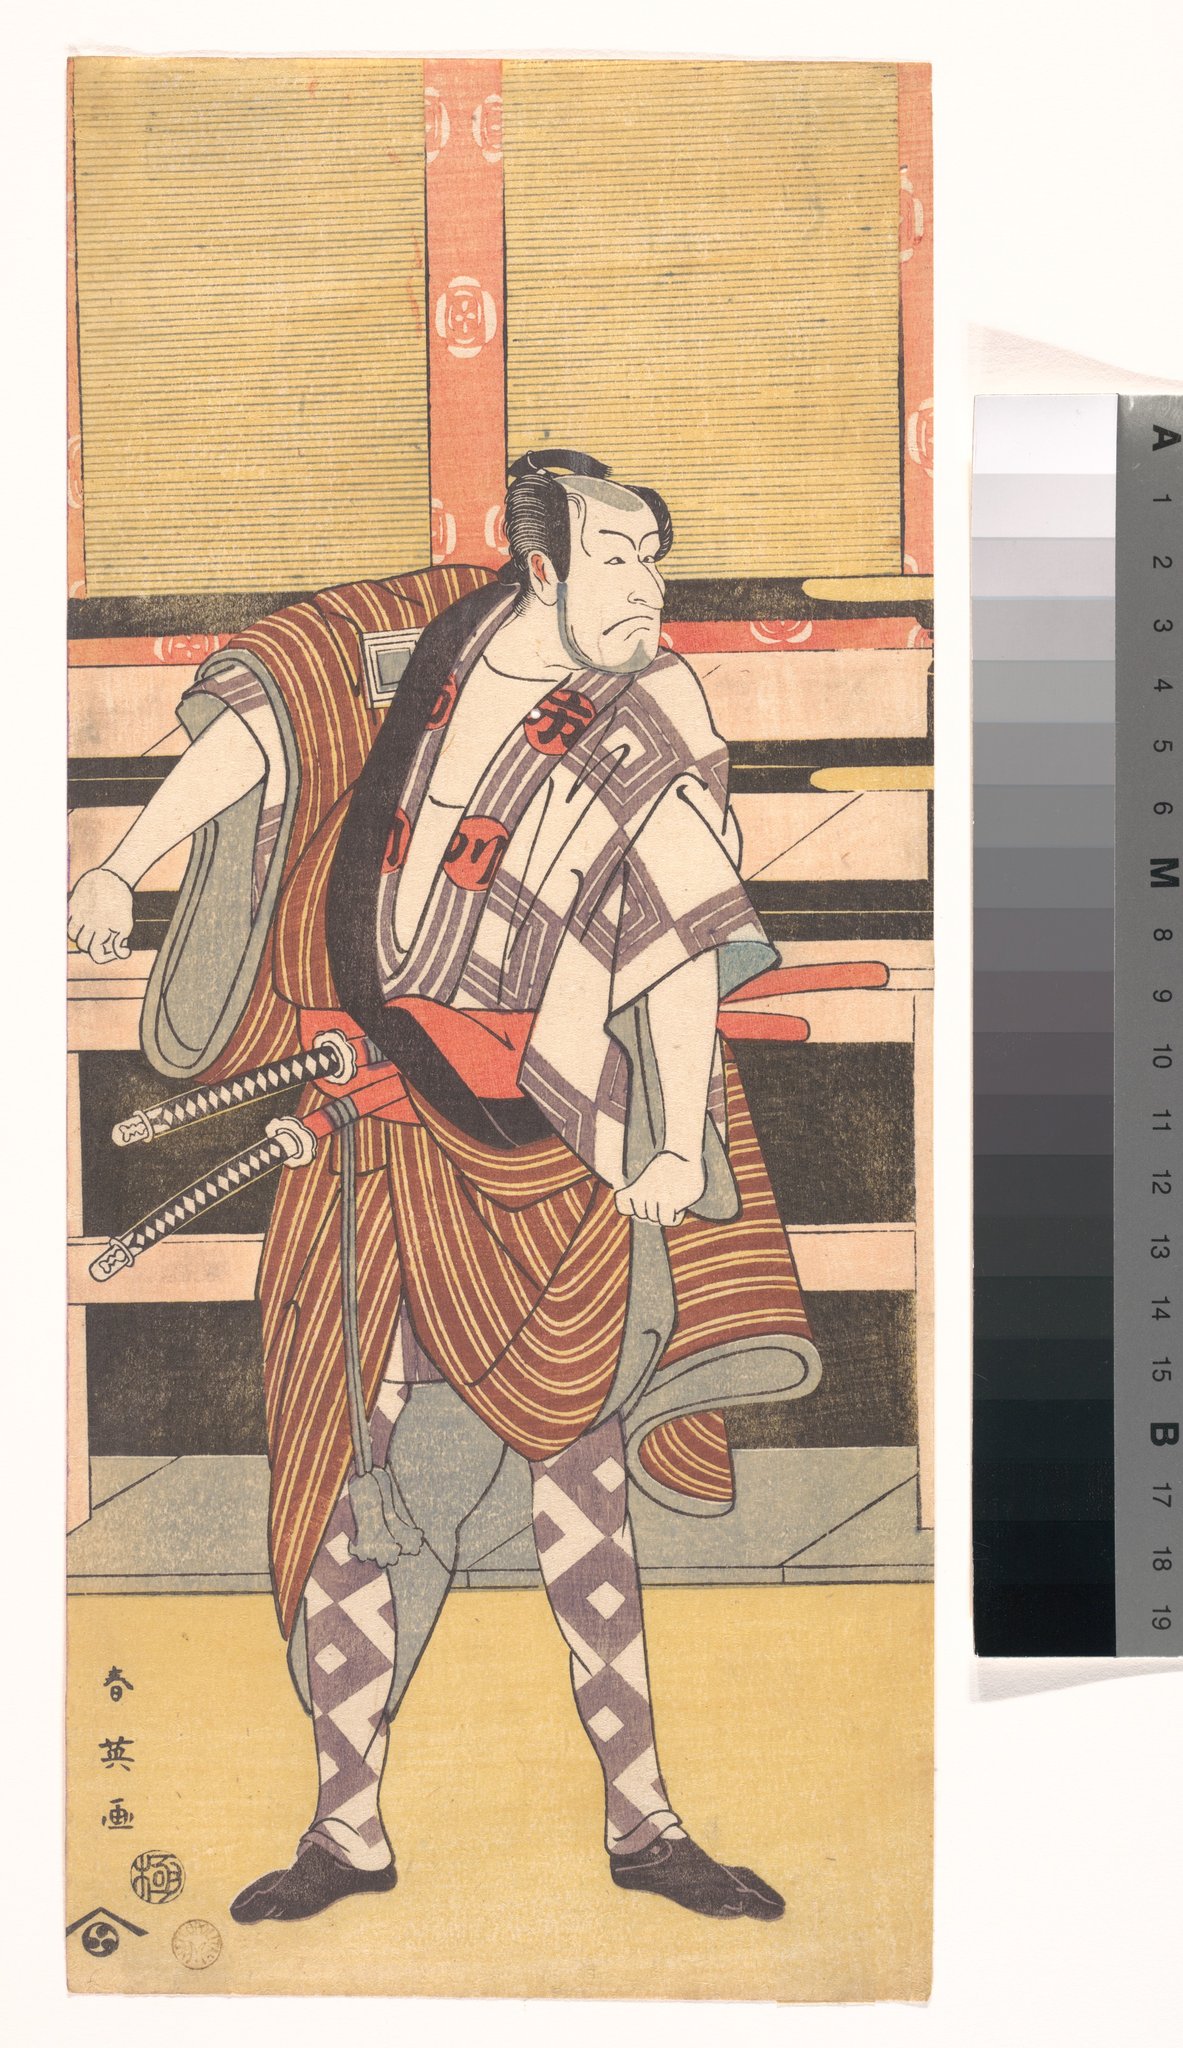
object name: print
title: The Actor Ichikawa Danjuro V as a Samurai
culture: japanese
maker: katsukawa shun'ei 勝川春英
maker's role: artist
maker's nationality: japanese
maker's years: 1762-1819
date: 1785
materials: ink, paper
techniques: woodblock print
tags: samurai,swords,actors